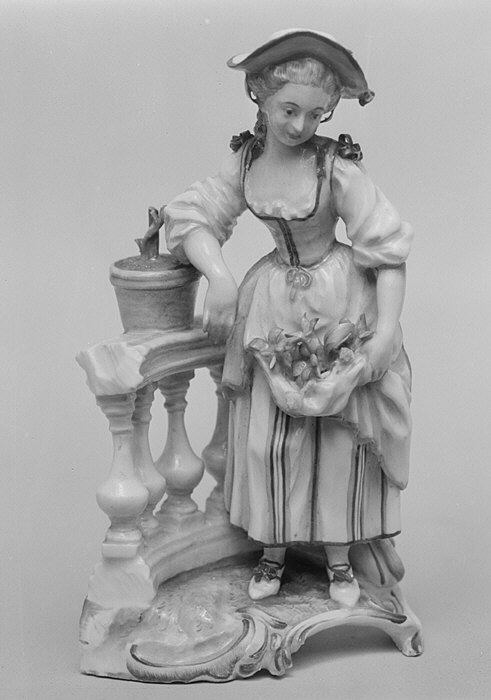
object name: figure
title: Gardener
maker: niderviller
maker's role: factory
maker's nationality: french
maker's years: 1735-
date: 1763-1770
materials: hard paste porcelain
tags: women,gardeners